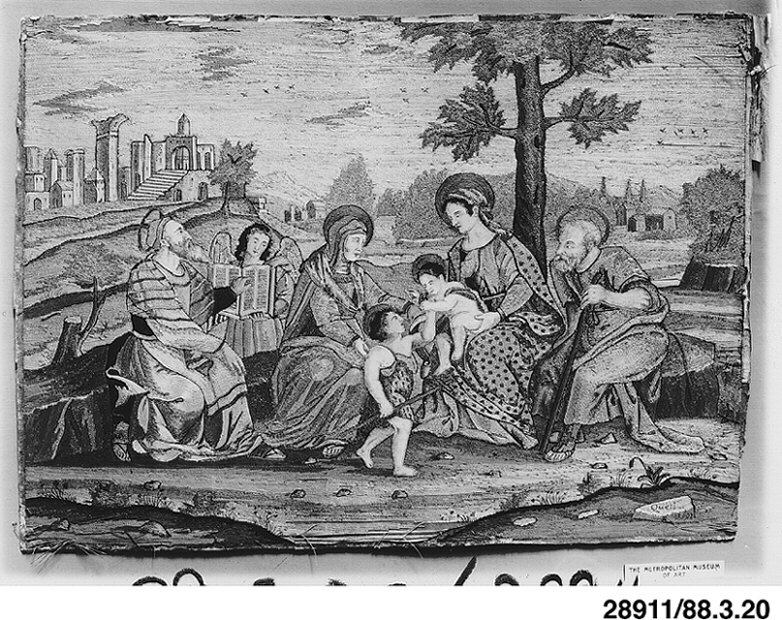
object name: embroidered picture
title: The Holy Family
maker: leonardus quesi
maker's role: maker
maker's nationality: french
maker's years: 1650-1750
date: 1667-1700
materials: cardboard, silk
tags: angels,holy family,virgin mary,jesus,saints